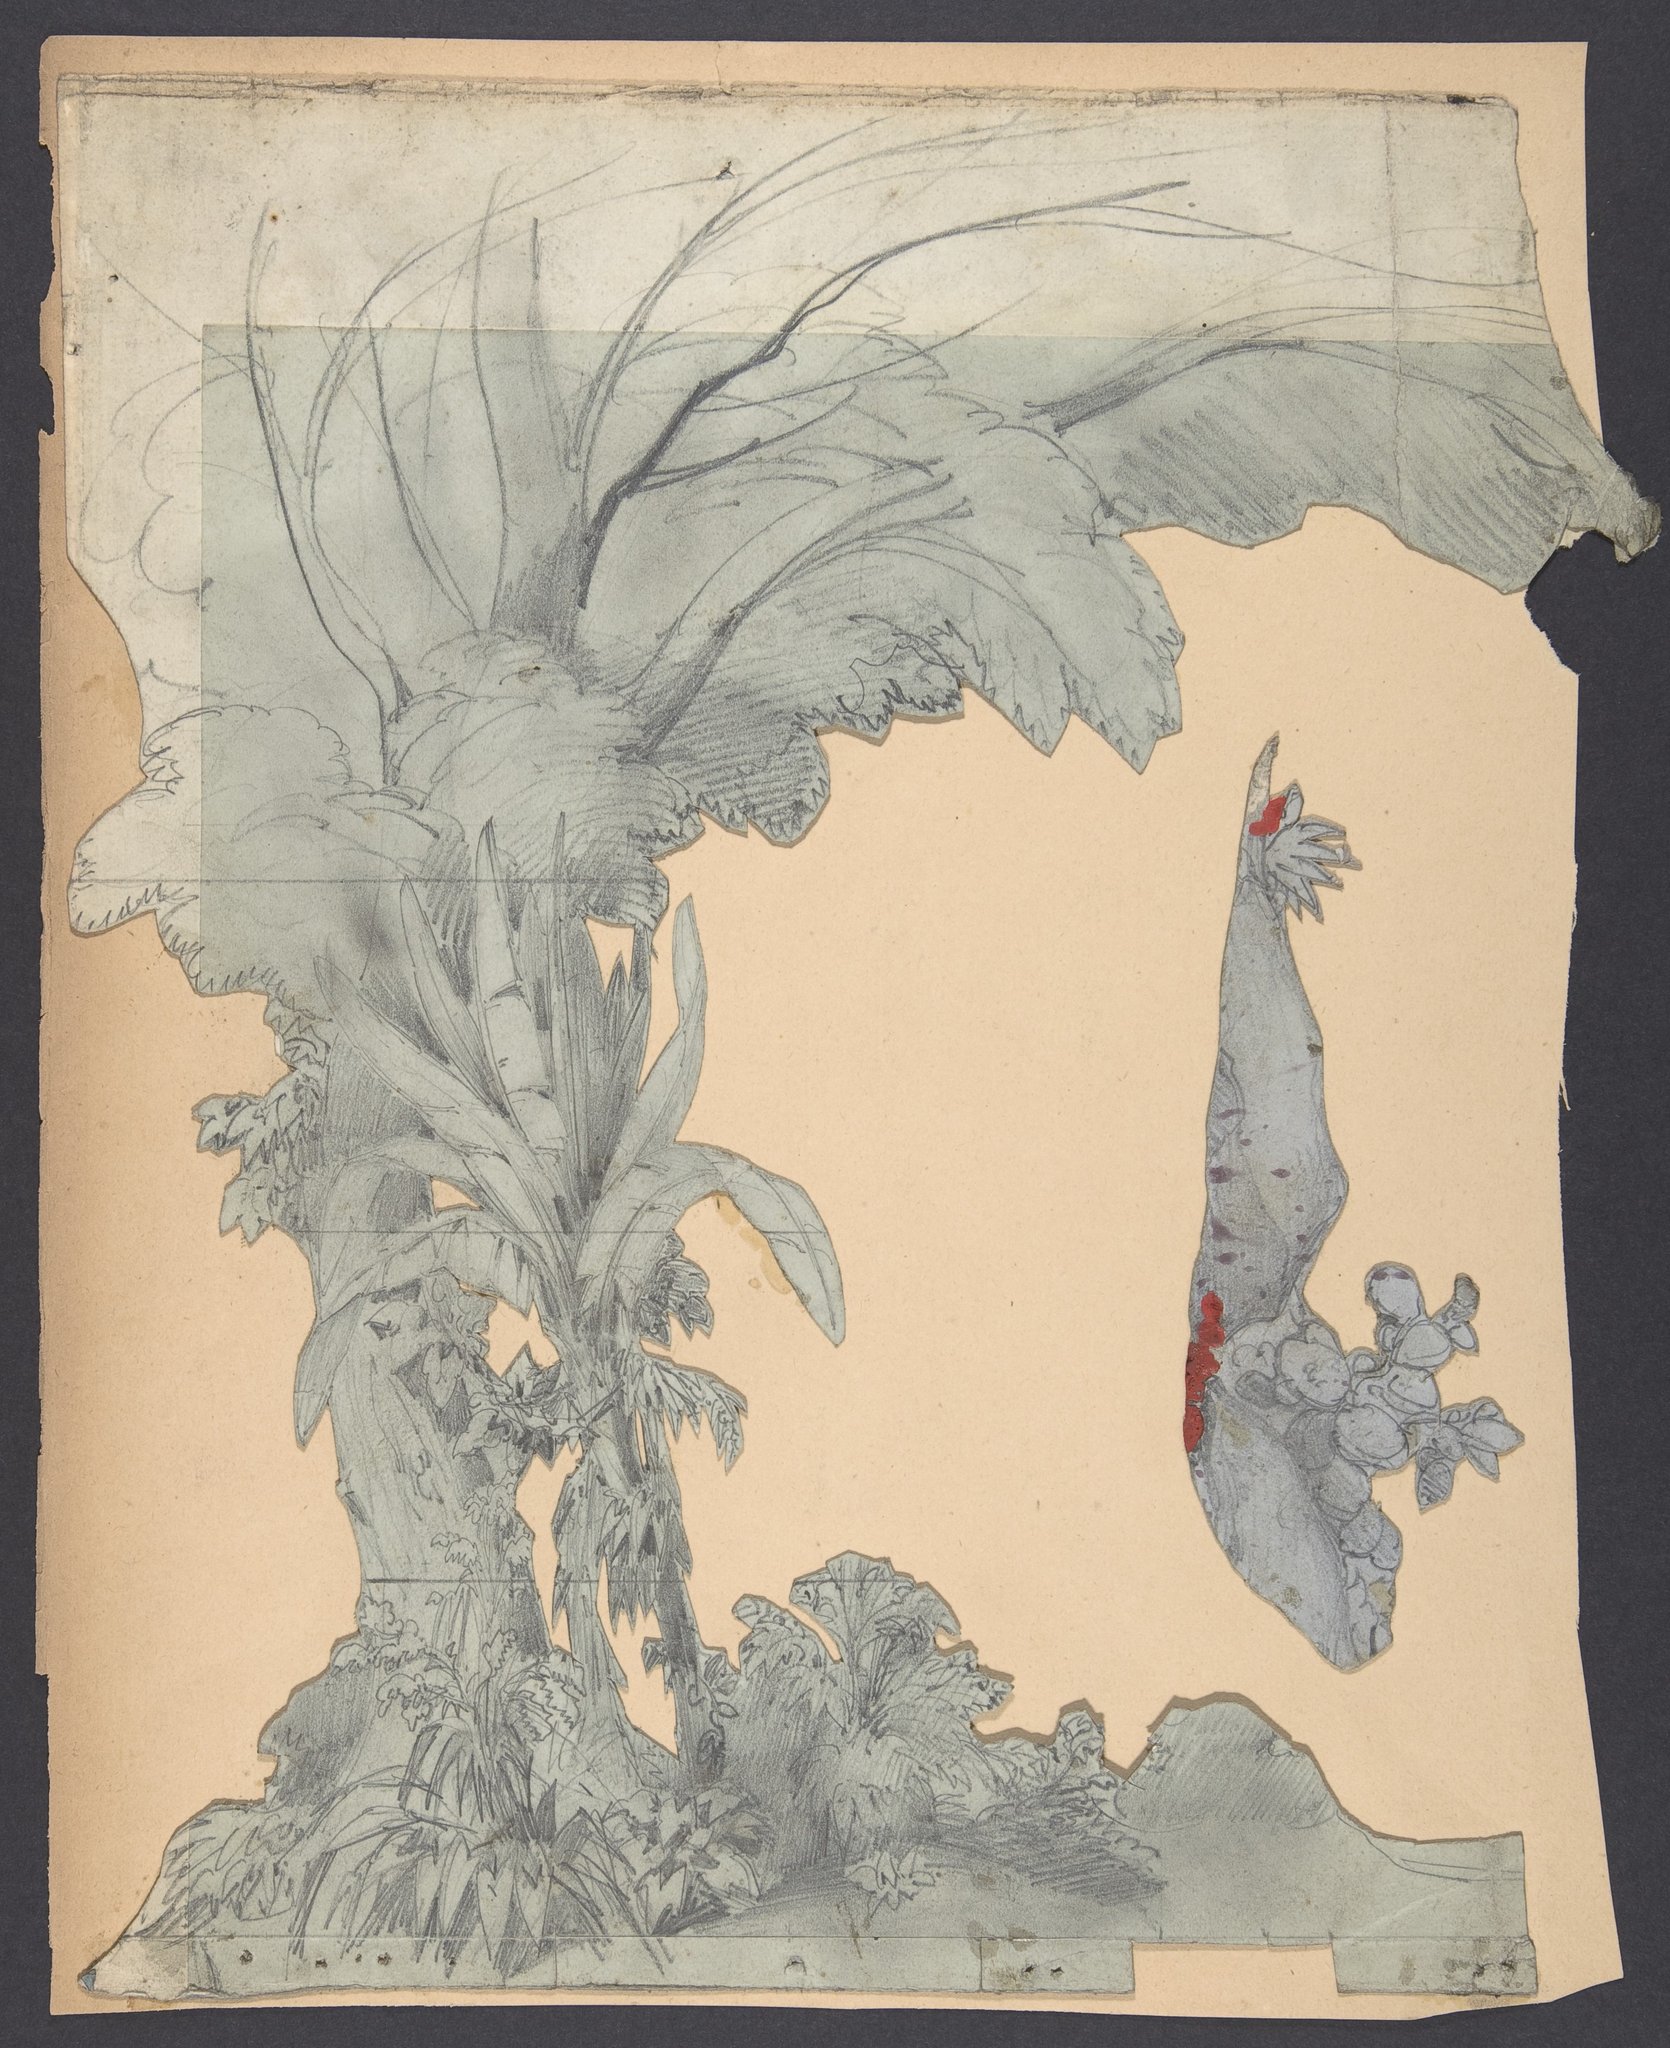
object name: drawing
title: Design for a Stage Set at the Opéra, Paris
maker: eugène cicéri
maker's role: artist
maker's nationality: french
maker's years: 1813-1890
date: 1828-1890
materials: graphite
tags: trees,stage design